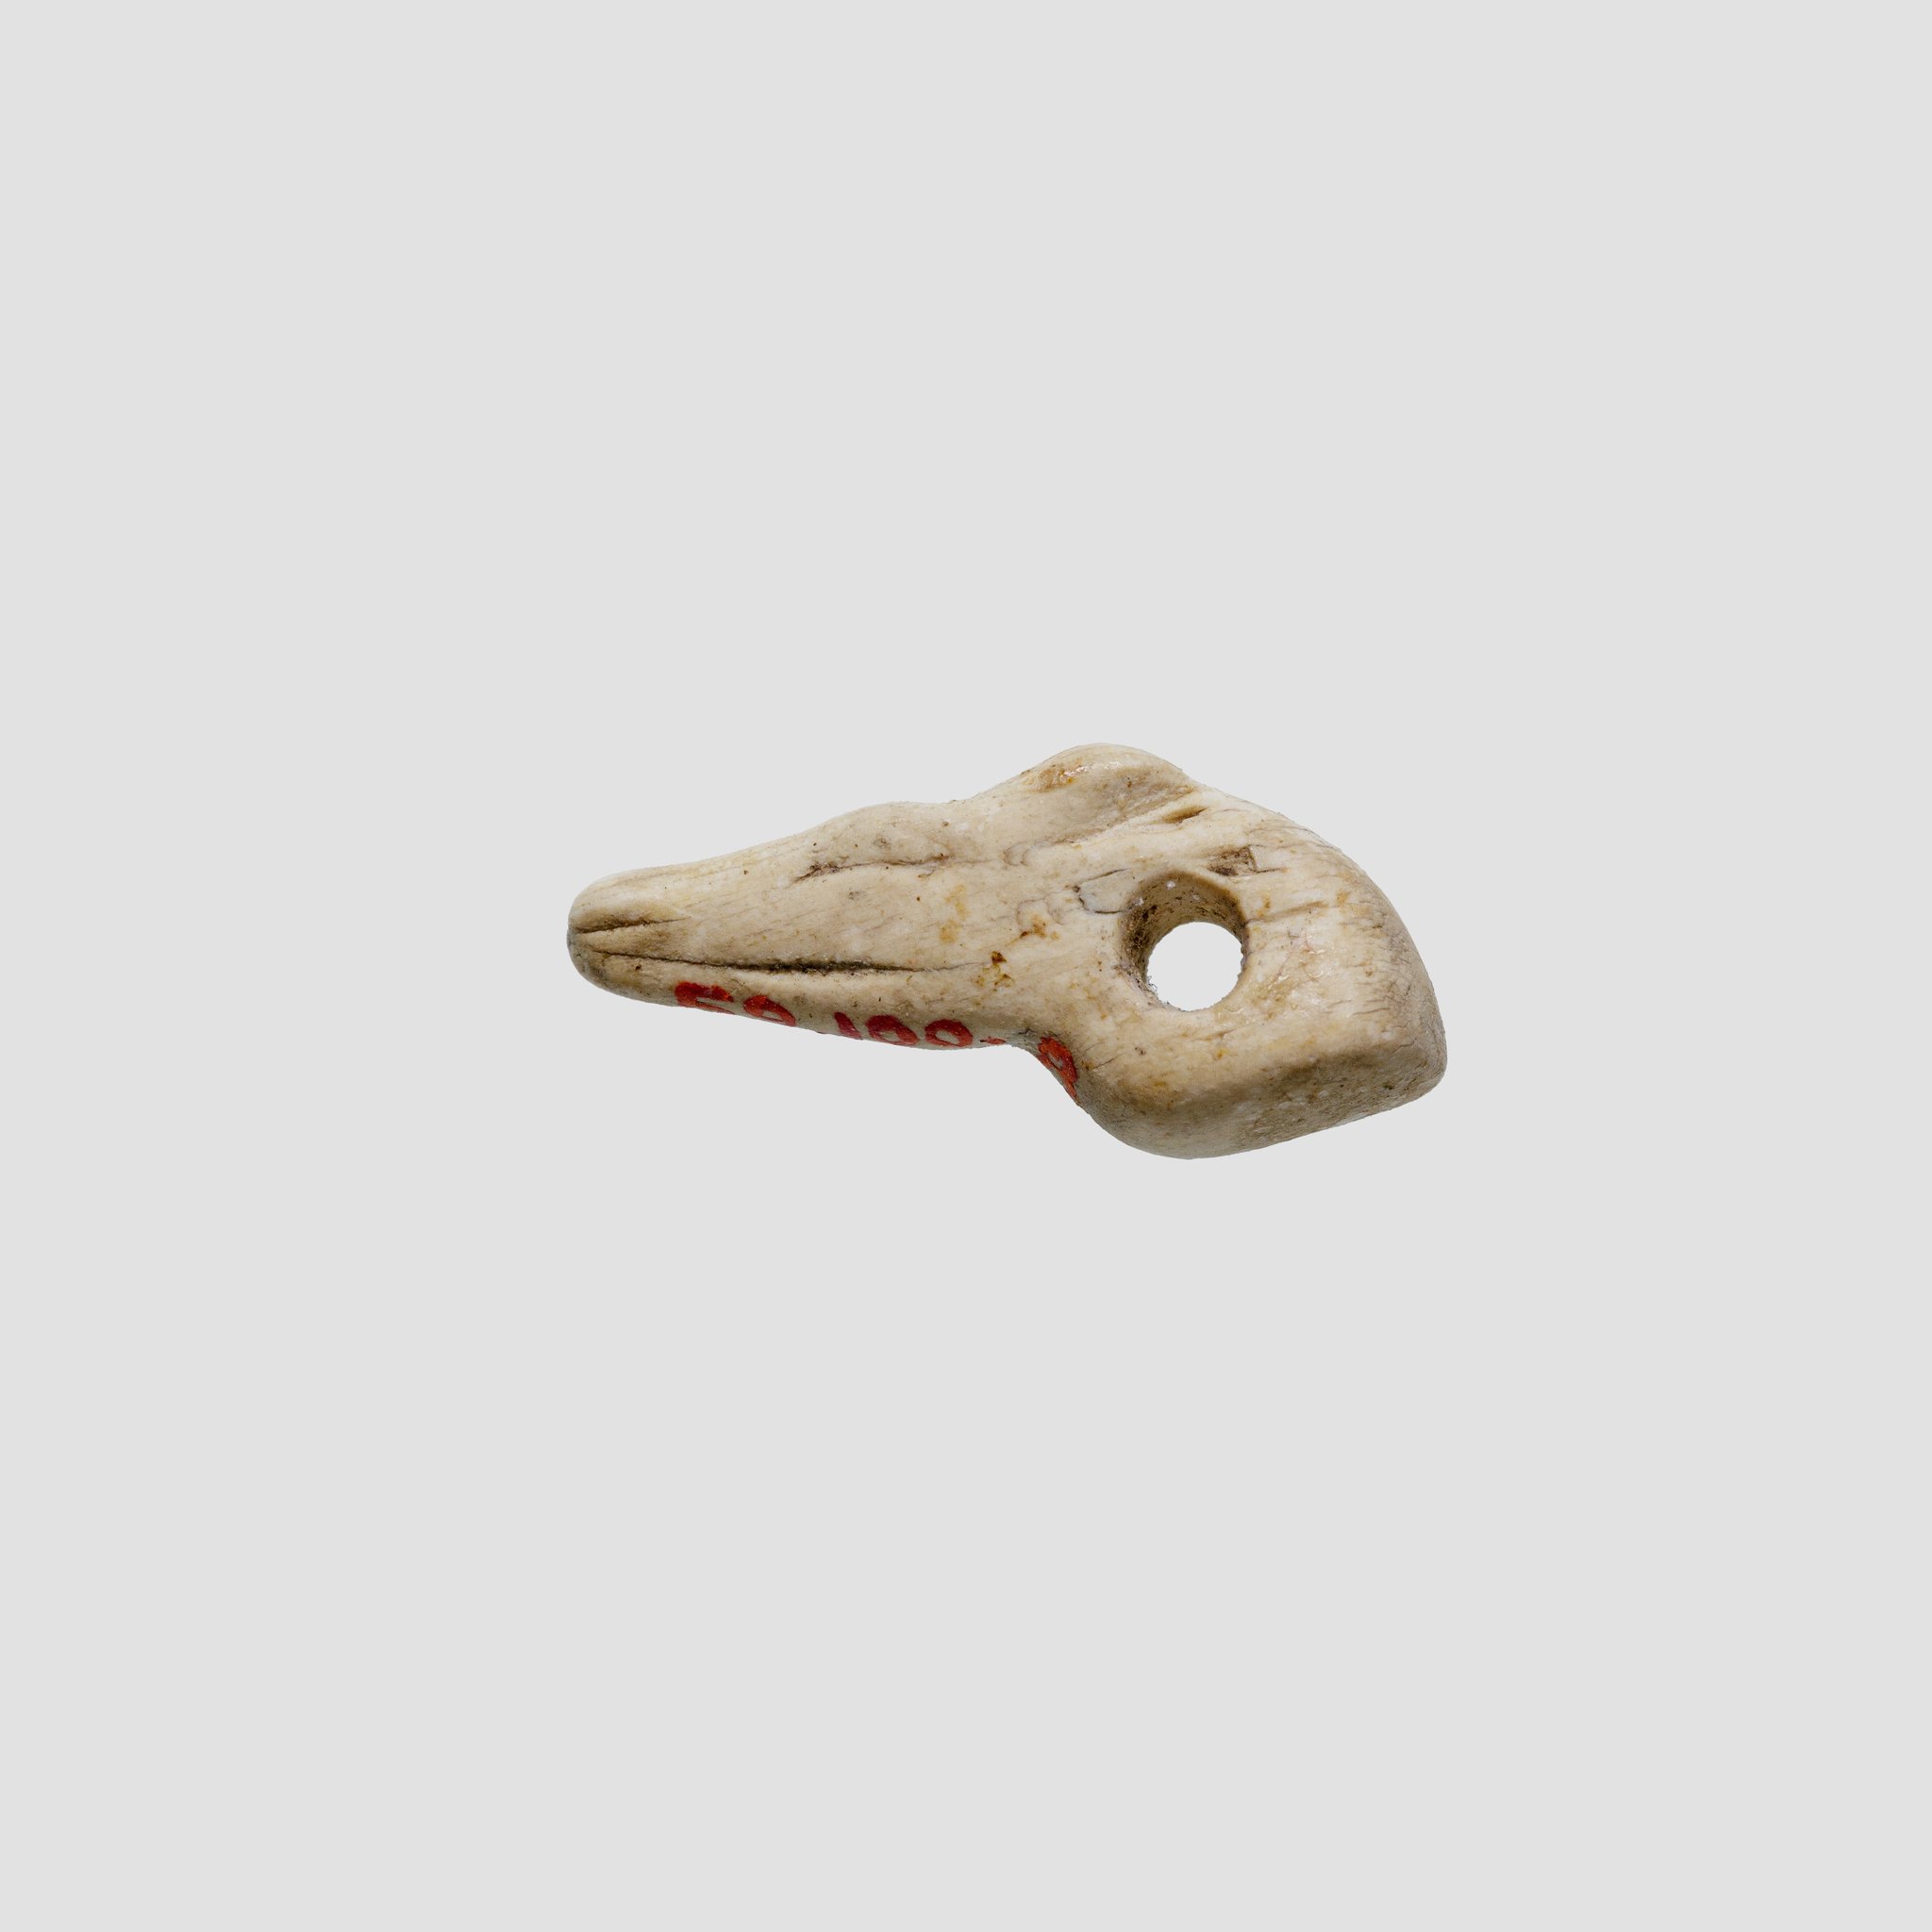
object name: amulet, jackal head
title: Jackal head amulet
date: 2150-1950 BCE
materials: bone, ivory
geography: egypt